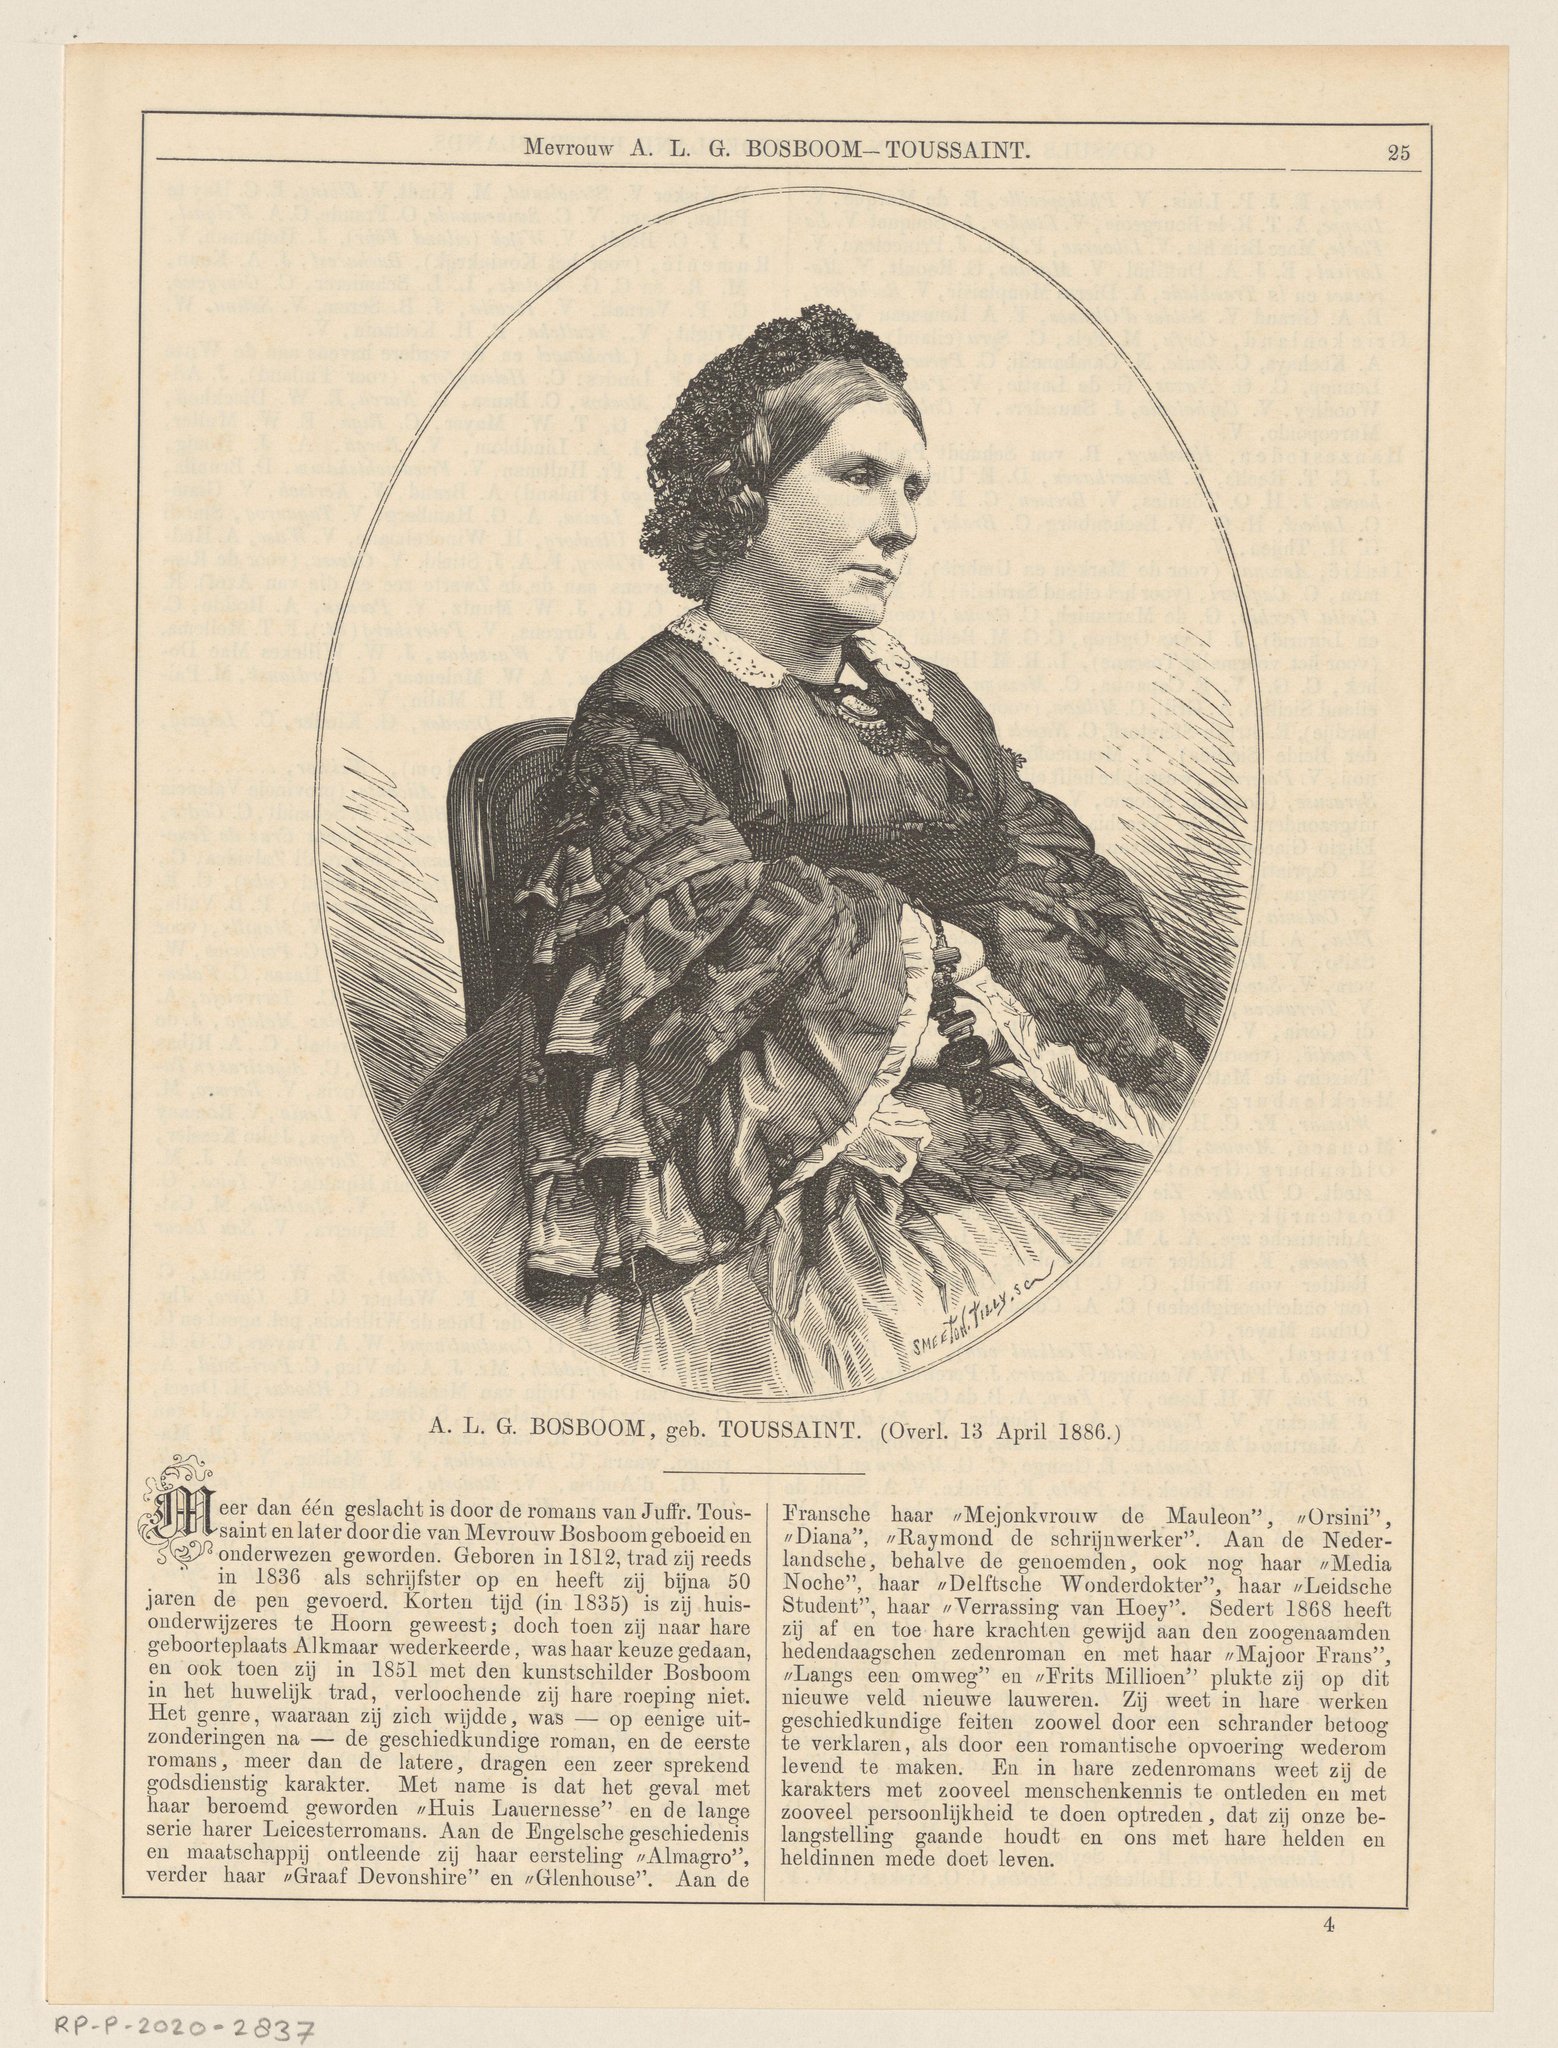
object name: print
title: Portret van Anna Louisa Geertruyda Bosboom-Toussaint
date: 1886-1888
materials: paper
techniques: letterpress printing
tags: the hague, anna louisa geertruyda bosboom-toussaint, historical persons - bb - woman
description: Prent waarschijnlijk uit: Nederandsche Almanak.